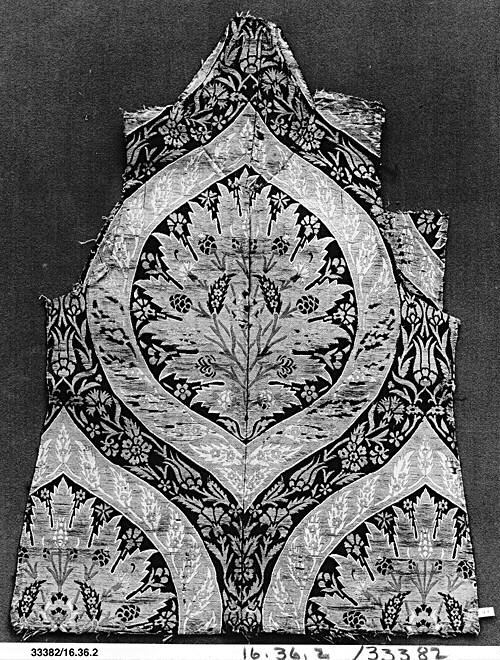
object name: textile fragment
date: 1501-1600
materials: silk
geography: turkey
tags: flowers